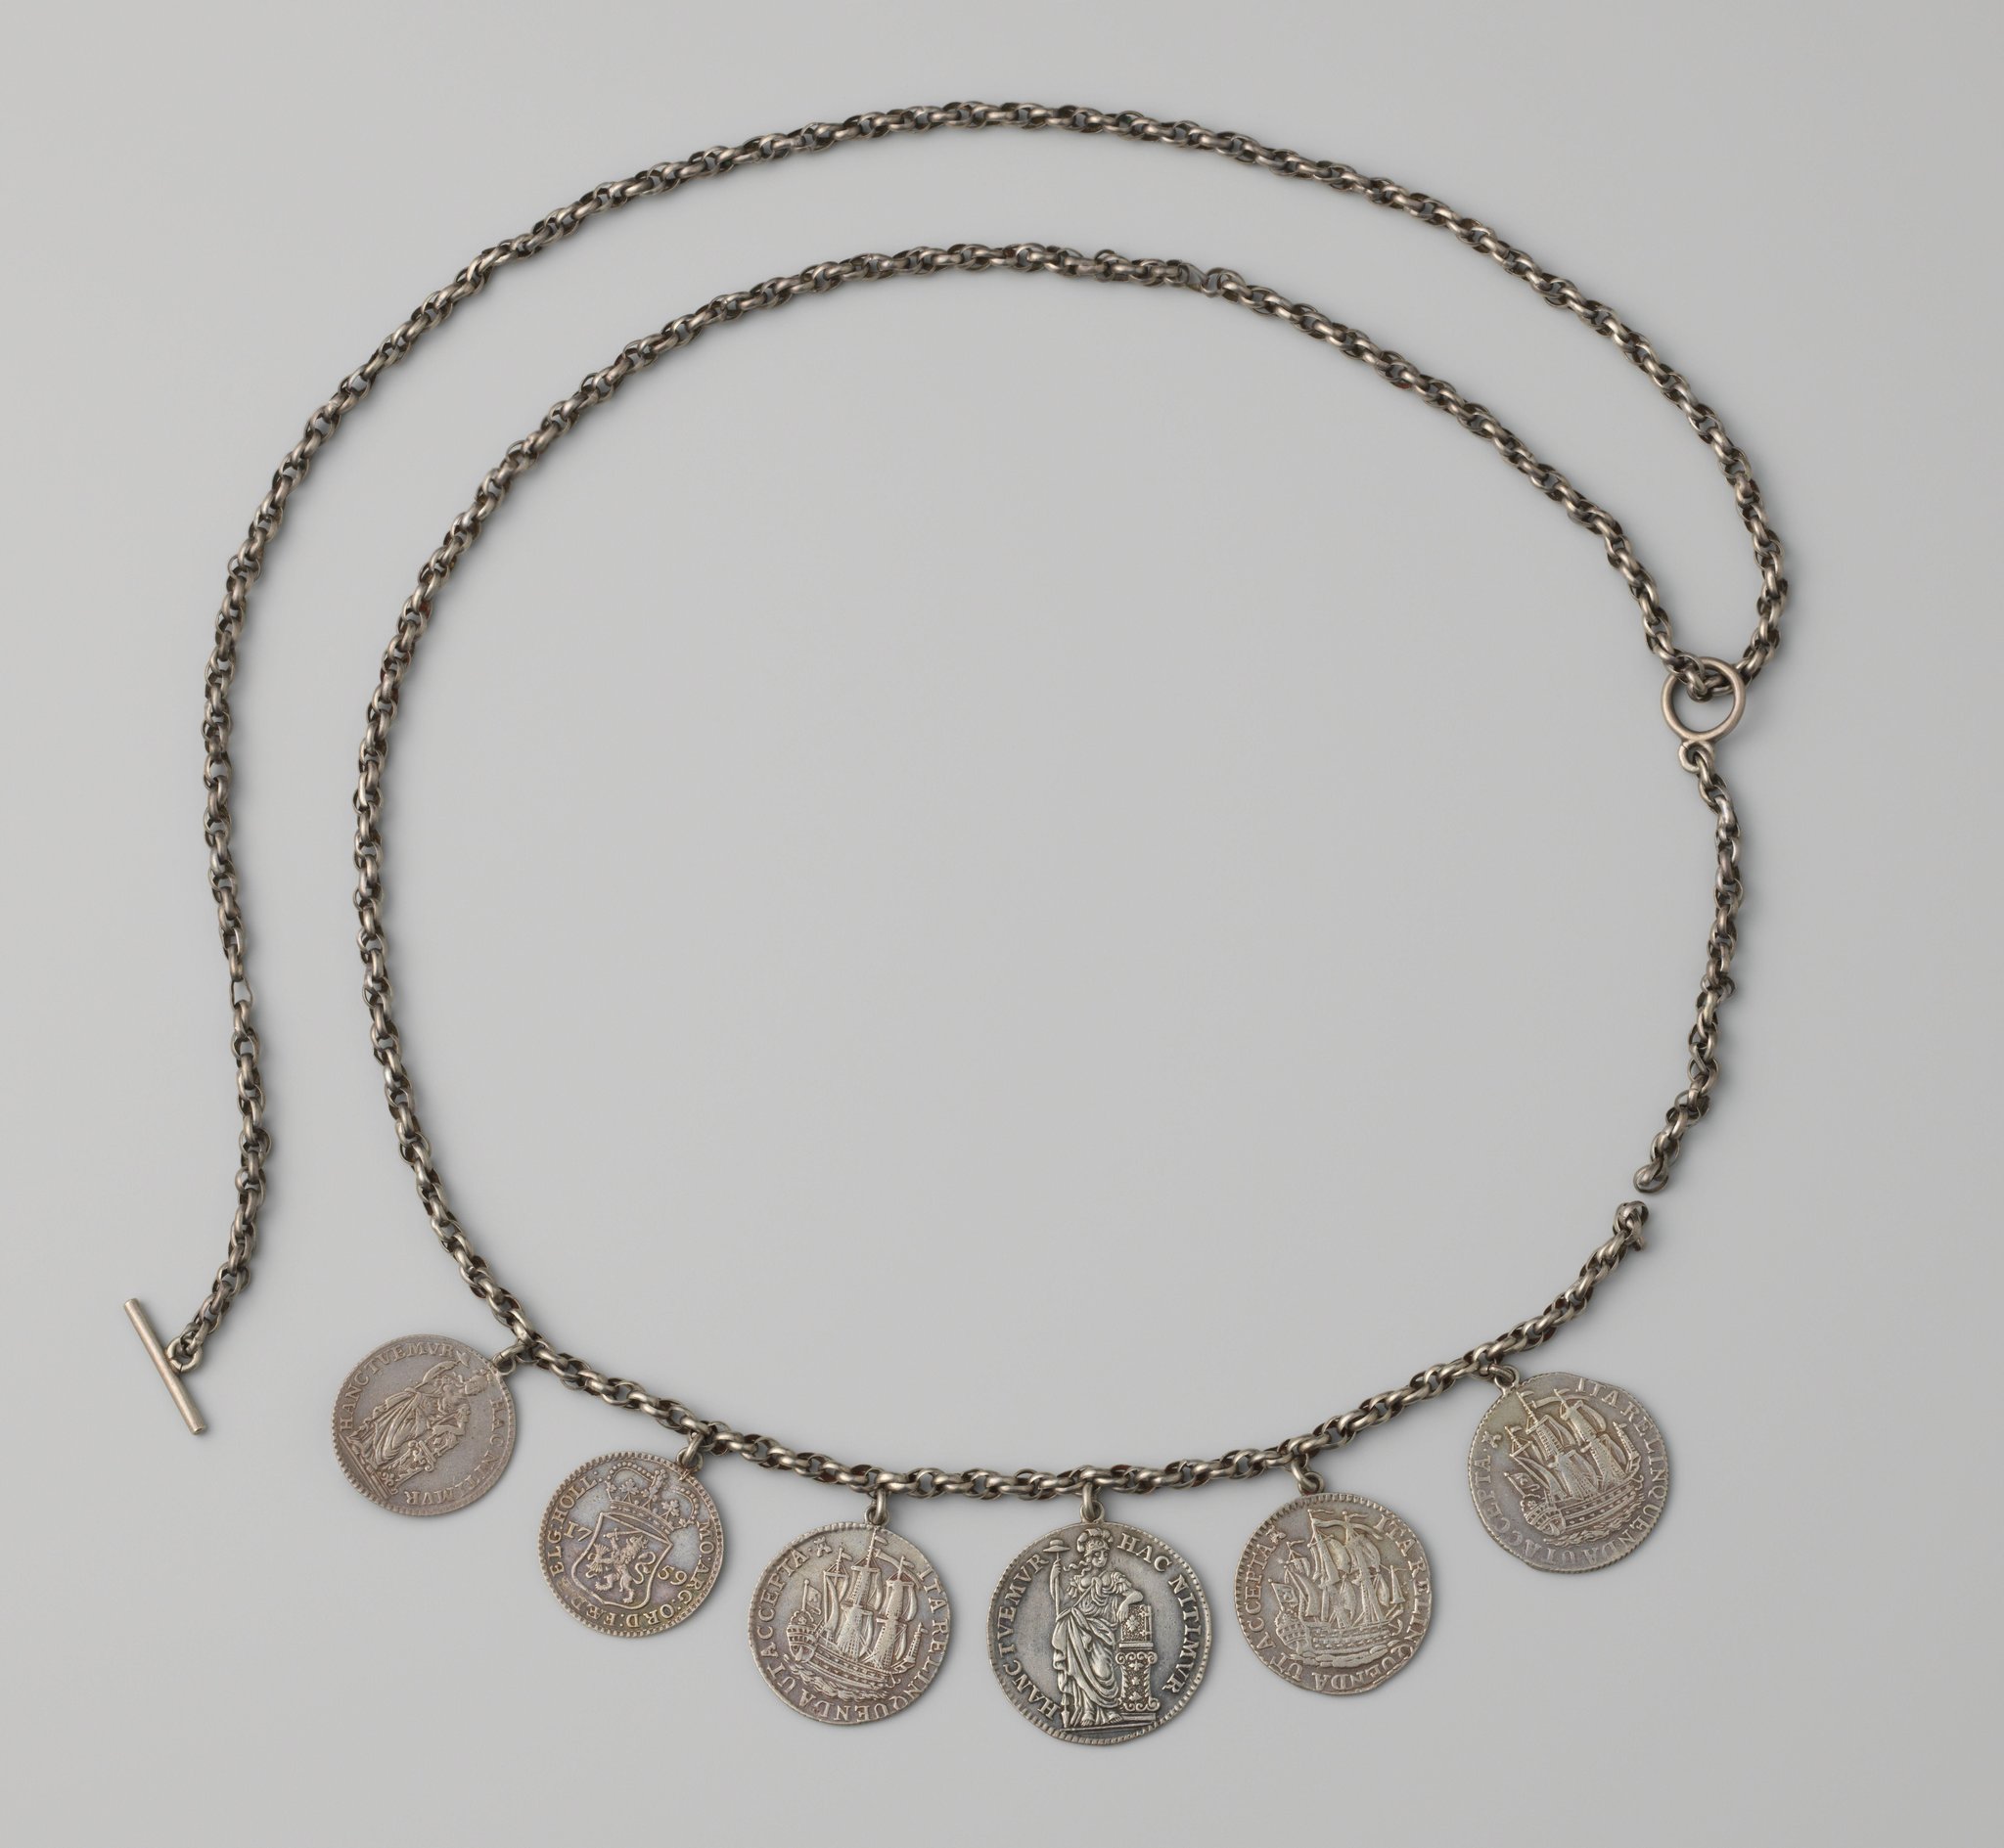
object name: chain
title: Ketting met zes munten in doos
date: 1800-1825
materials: silver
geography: netherlands